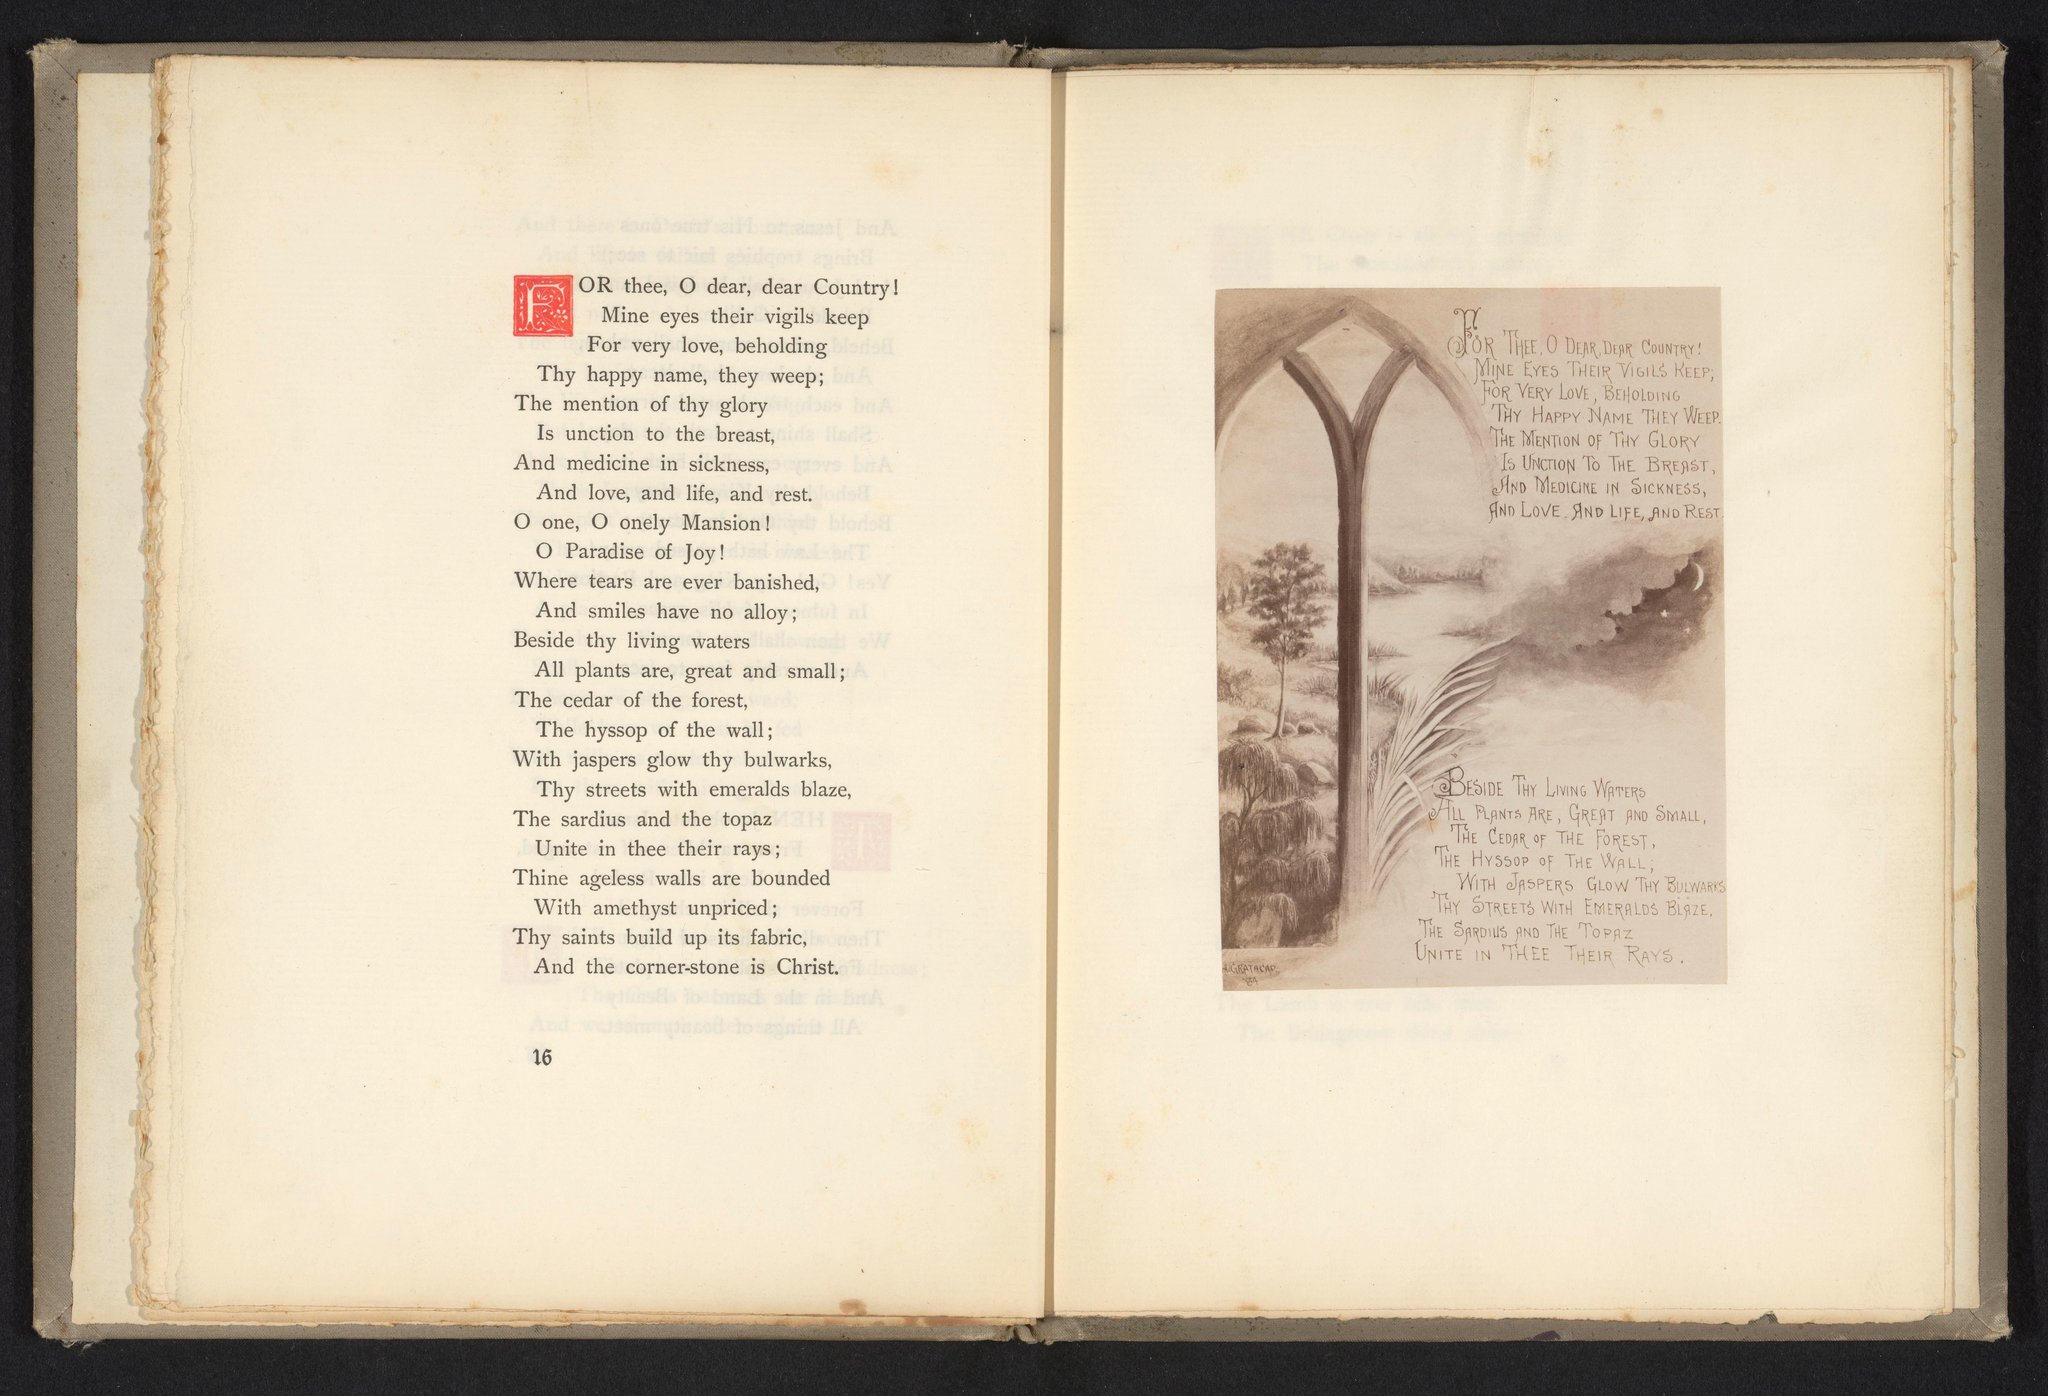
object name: page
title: Fotoreproductie van een vers van het gedicht The celestial country met afbeeldingen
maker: Anonymous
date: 1884-1885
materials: photographic support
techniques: albumen print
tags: church-window, e.g. rose-window, handwriting, written text